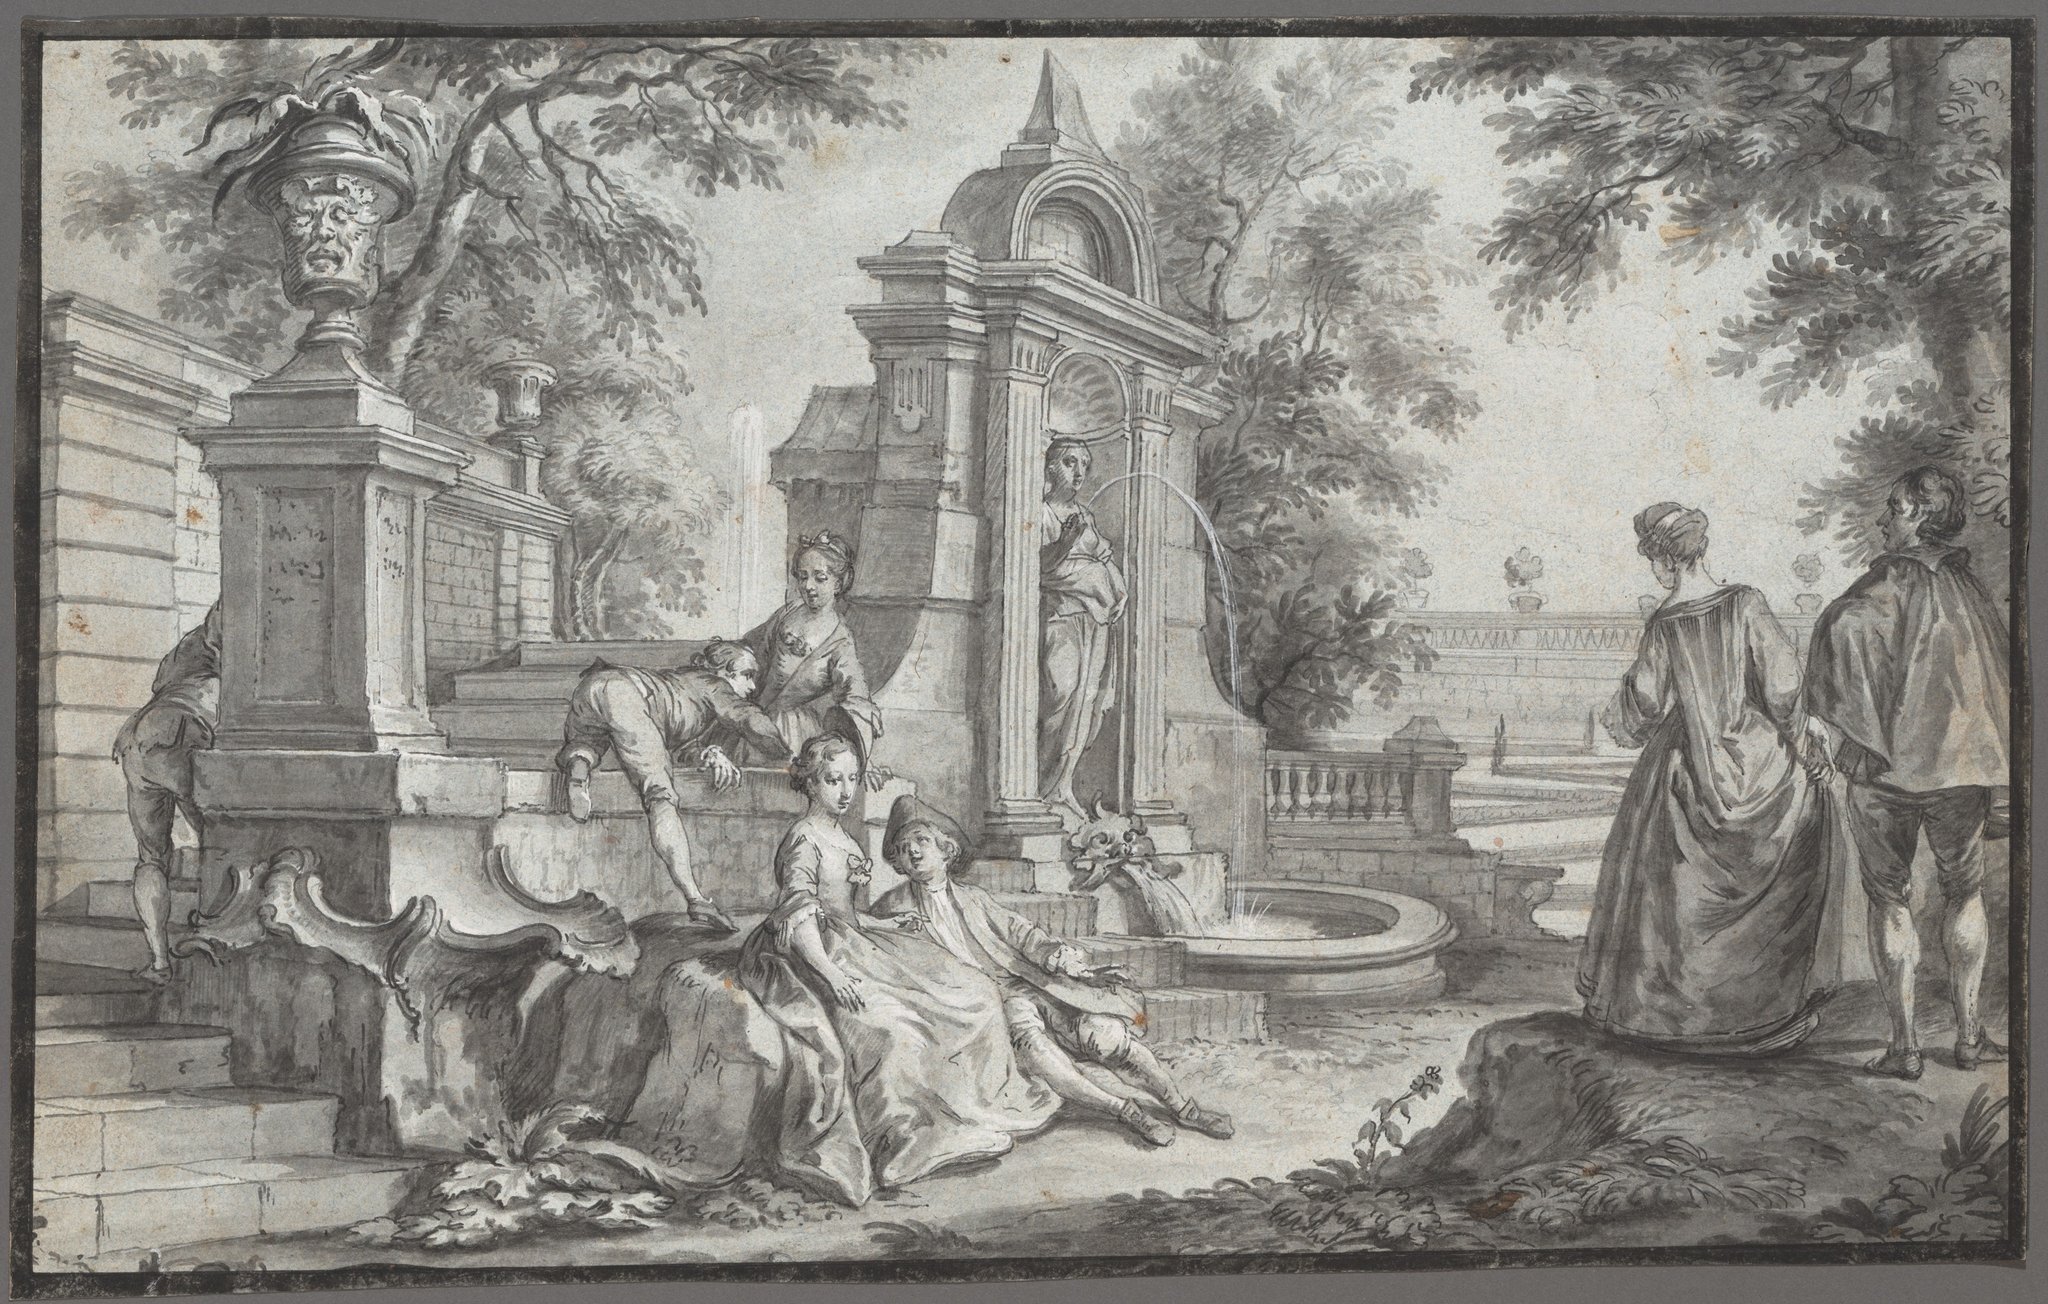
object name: drawing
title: Gallant Company in a Park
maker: johann wolfgang baumgartner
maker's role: artist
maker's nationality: german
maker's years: 1712-1761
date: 1734-1766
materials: chalk, gouache, ink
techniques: brush, heightening, incising, pen, transfer, wash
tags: fountains,parks,men,women